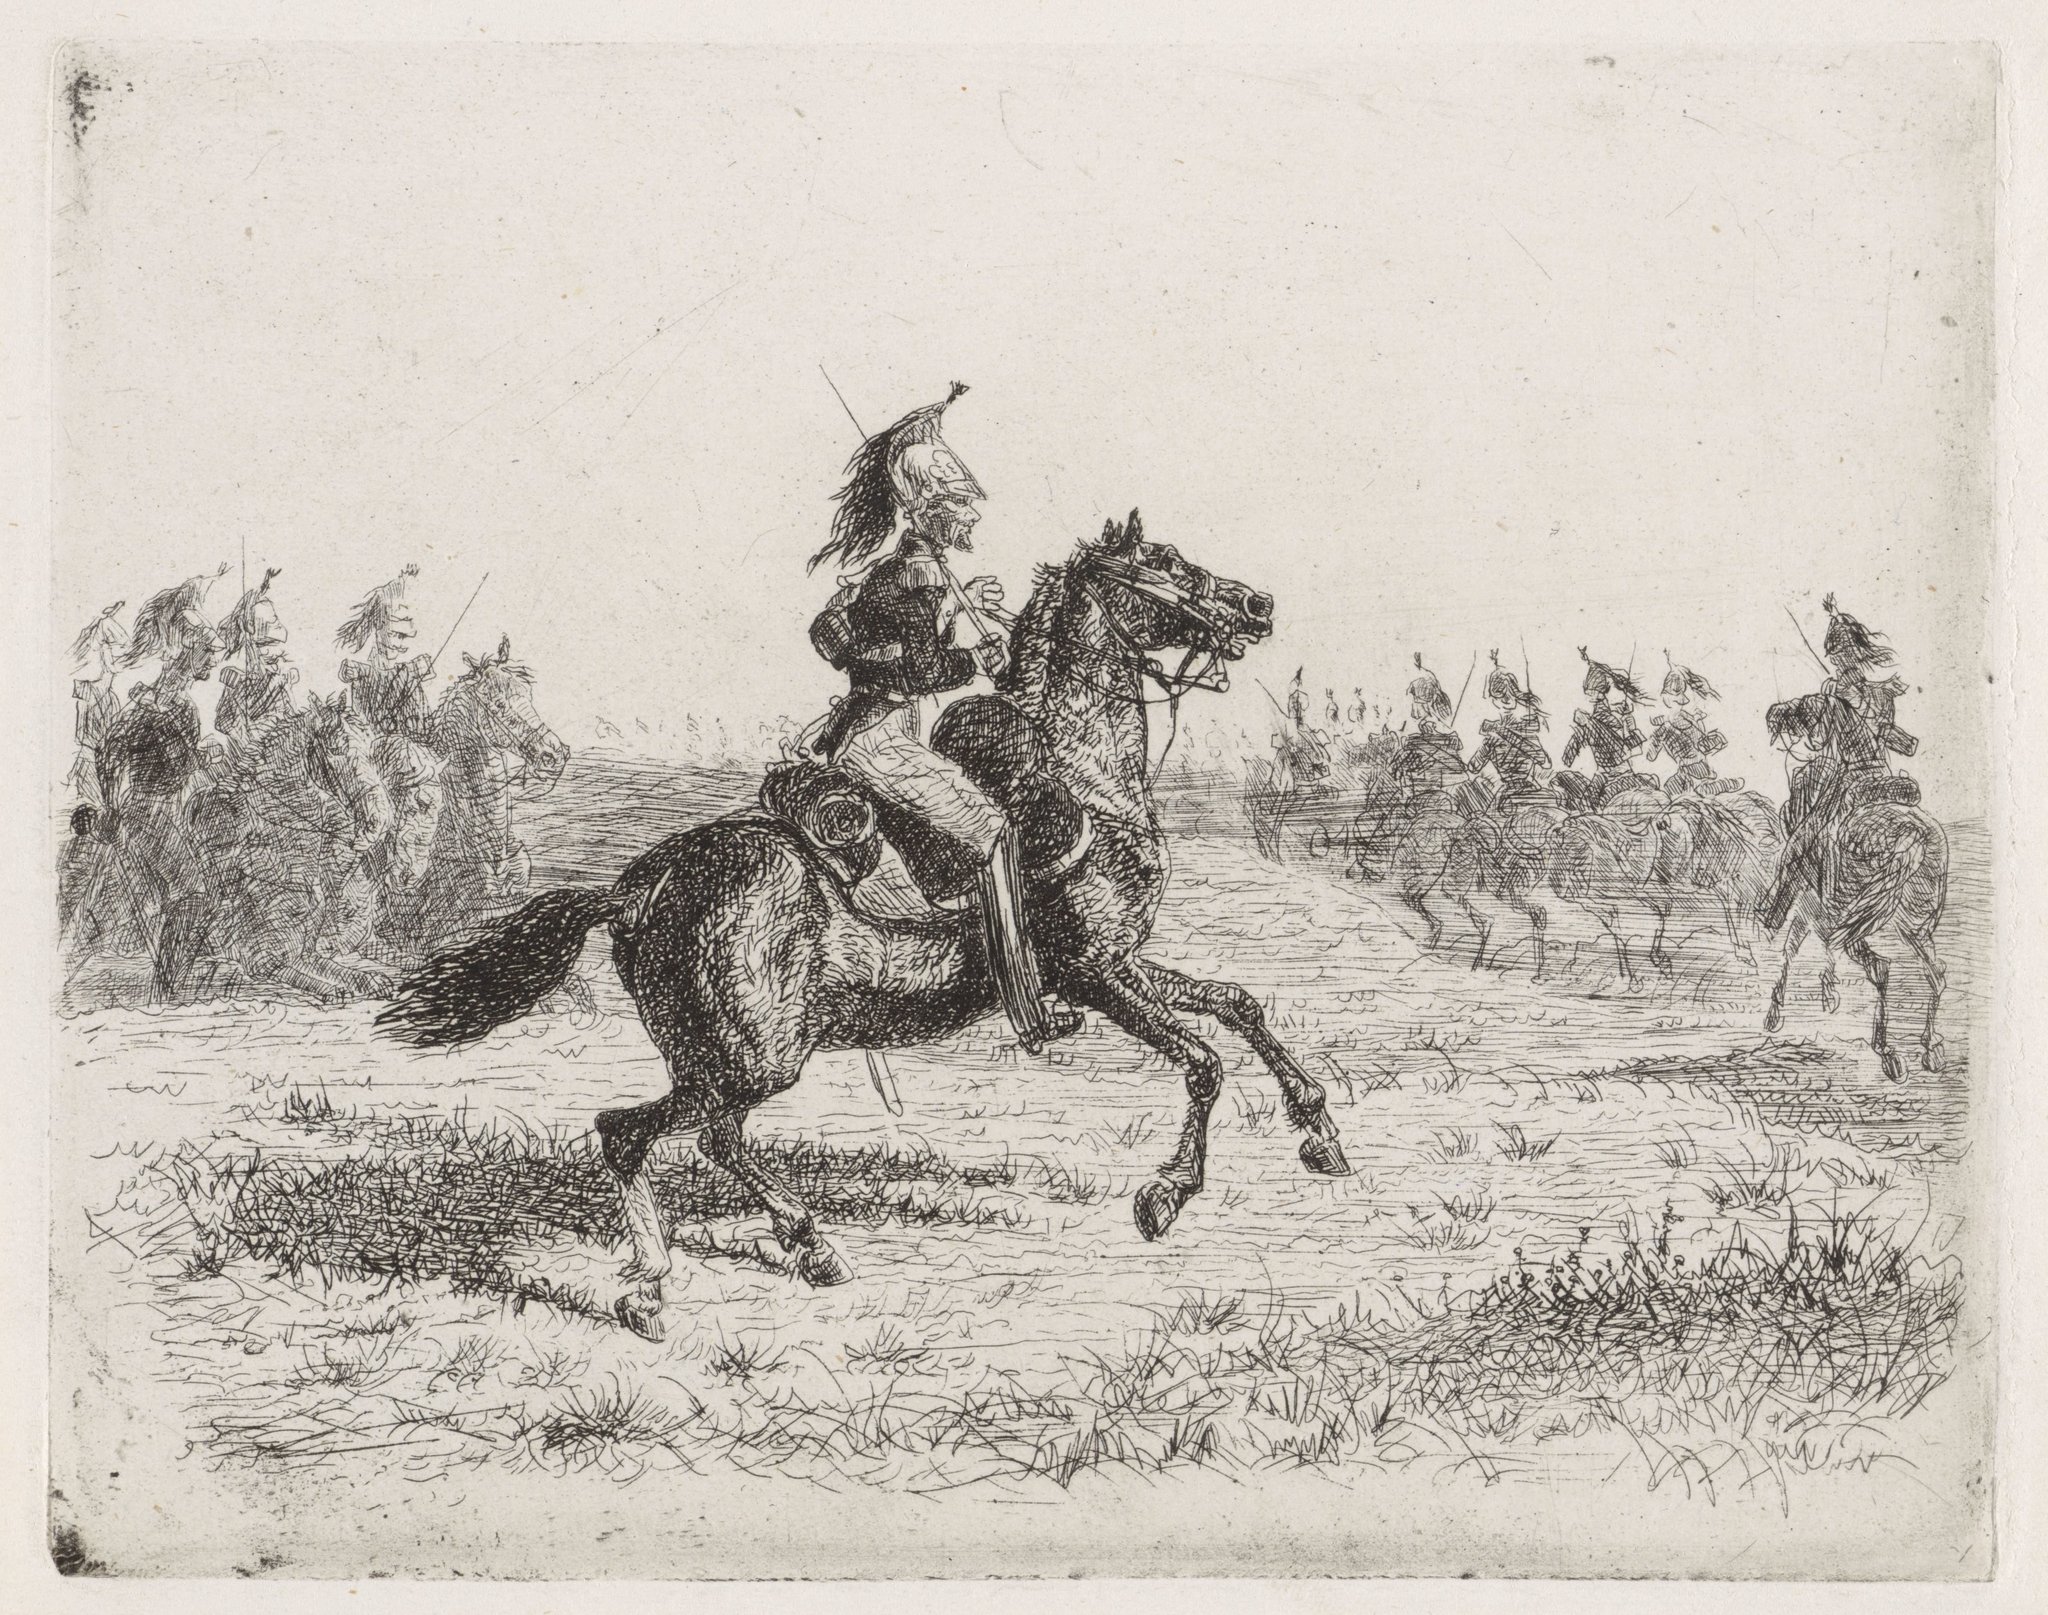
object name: print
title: Landschap met cavaleristen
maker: cornelis albertus johannes schermer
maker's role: draughtsman, painter, print maker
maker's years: 1824-1915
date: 1865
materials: paper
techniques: etching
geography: the hague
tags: the soldier; the soldier's life (+ cavalry, horsemen)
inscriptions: collector's mark: Lugt 2228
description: Vooraan een wachtmeester in wapenrusting op een paard in galop. Achter hem enkele cavaleristen, dragonders, op galopperende paarden.